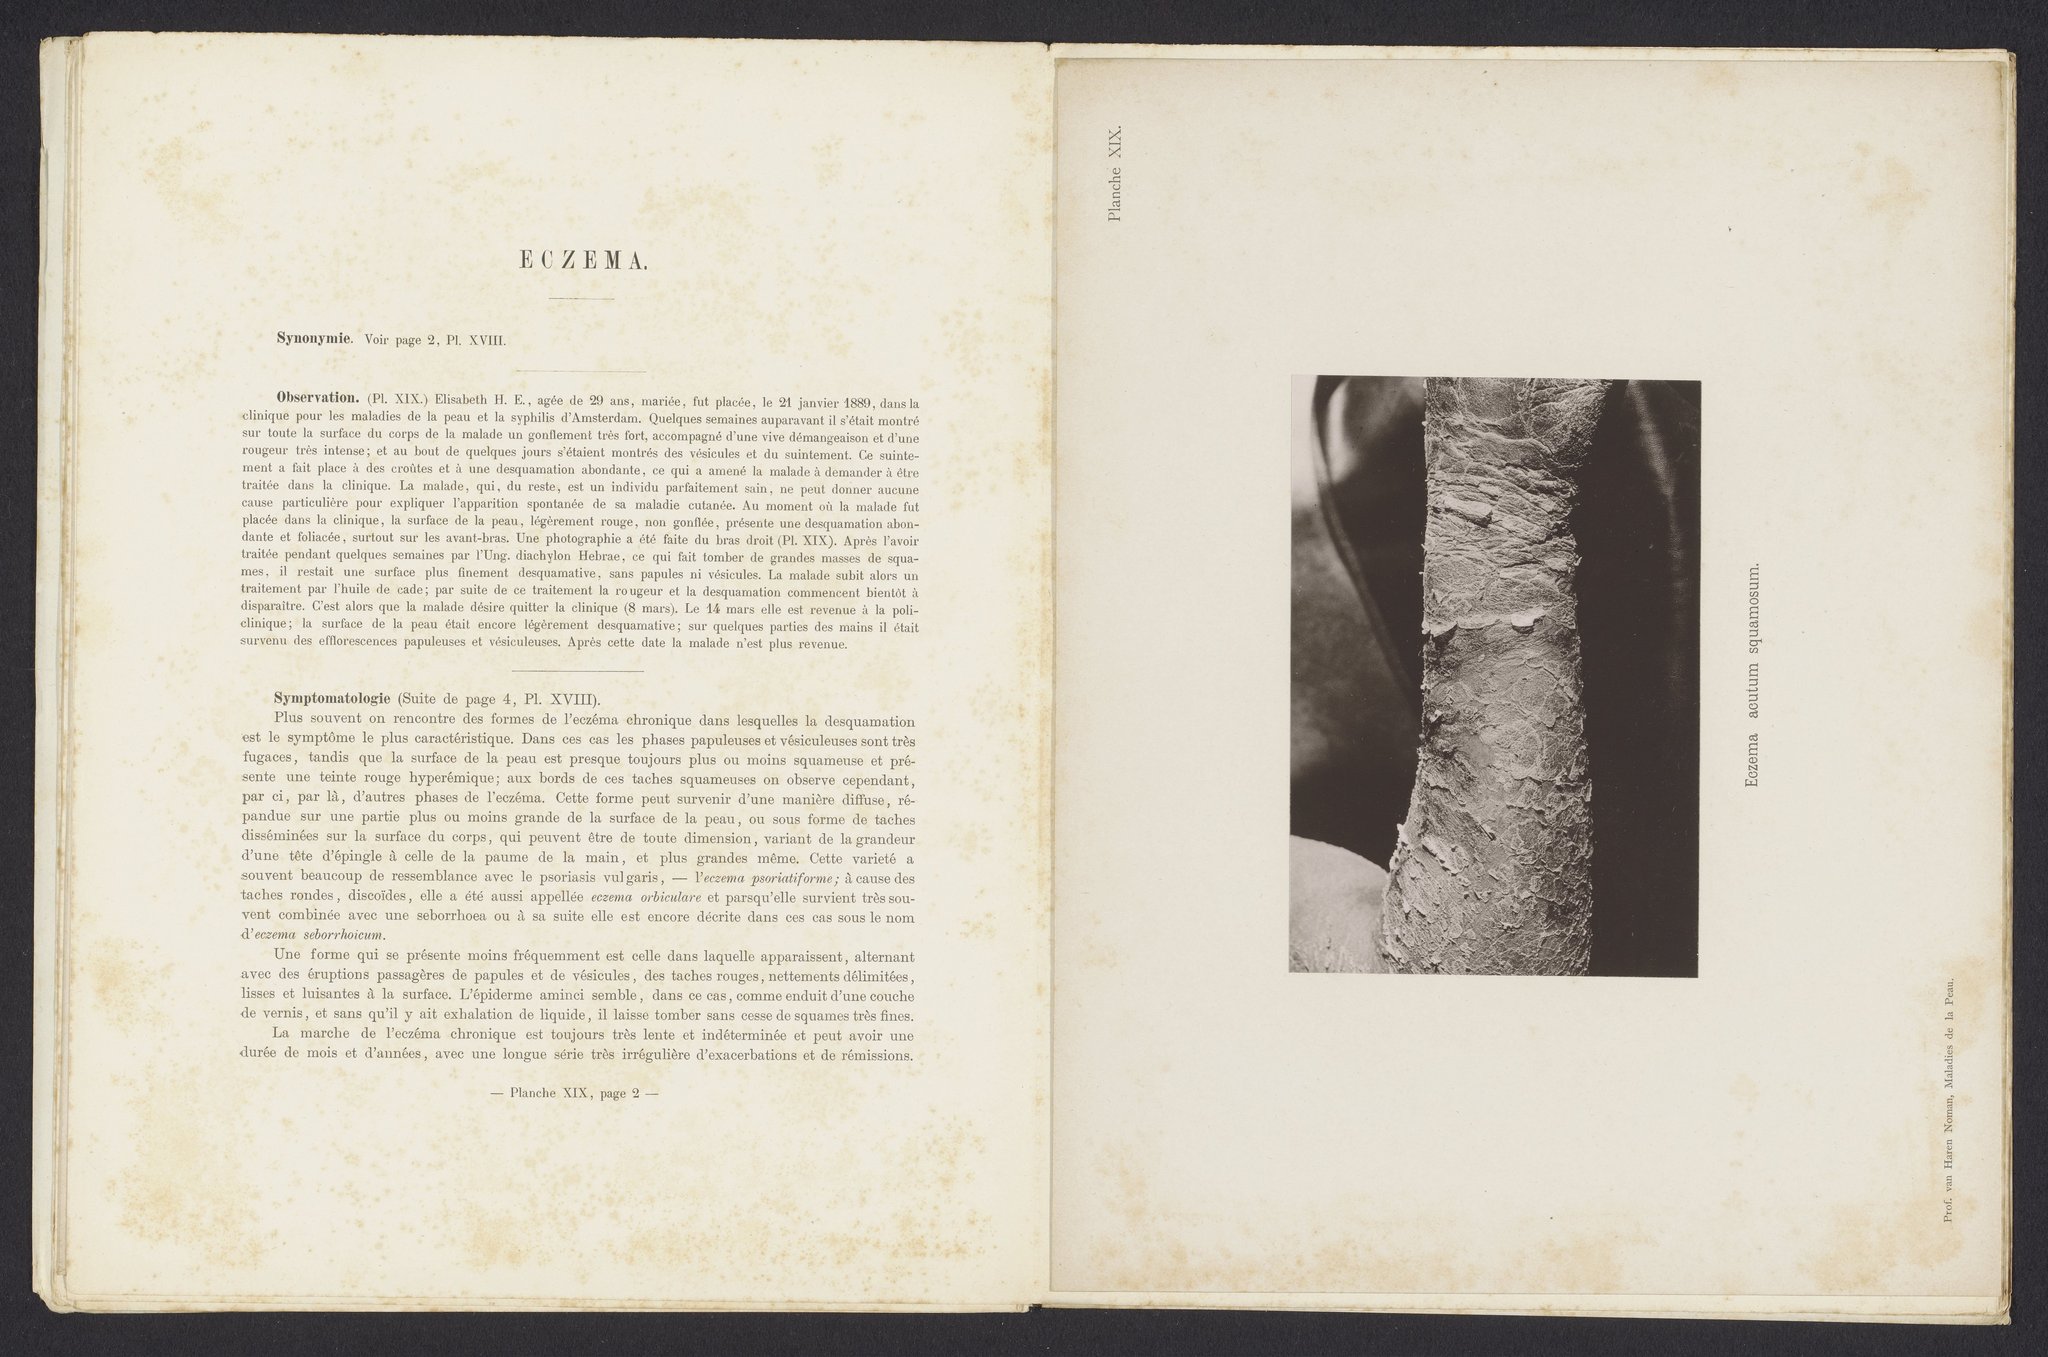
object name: photomechanical print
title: Eczema acutum squamosum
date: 1880-1890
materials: paper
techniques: photograph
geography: haarlem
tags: skin and venereal diseases, arms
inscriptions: number: ‘Planche XIX.’